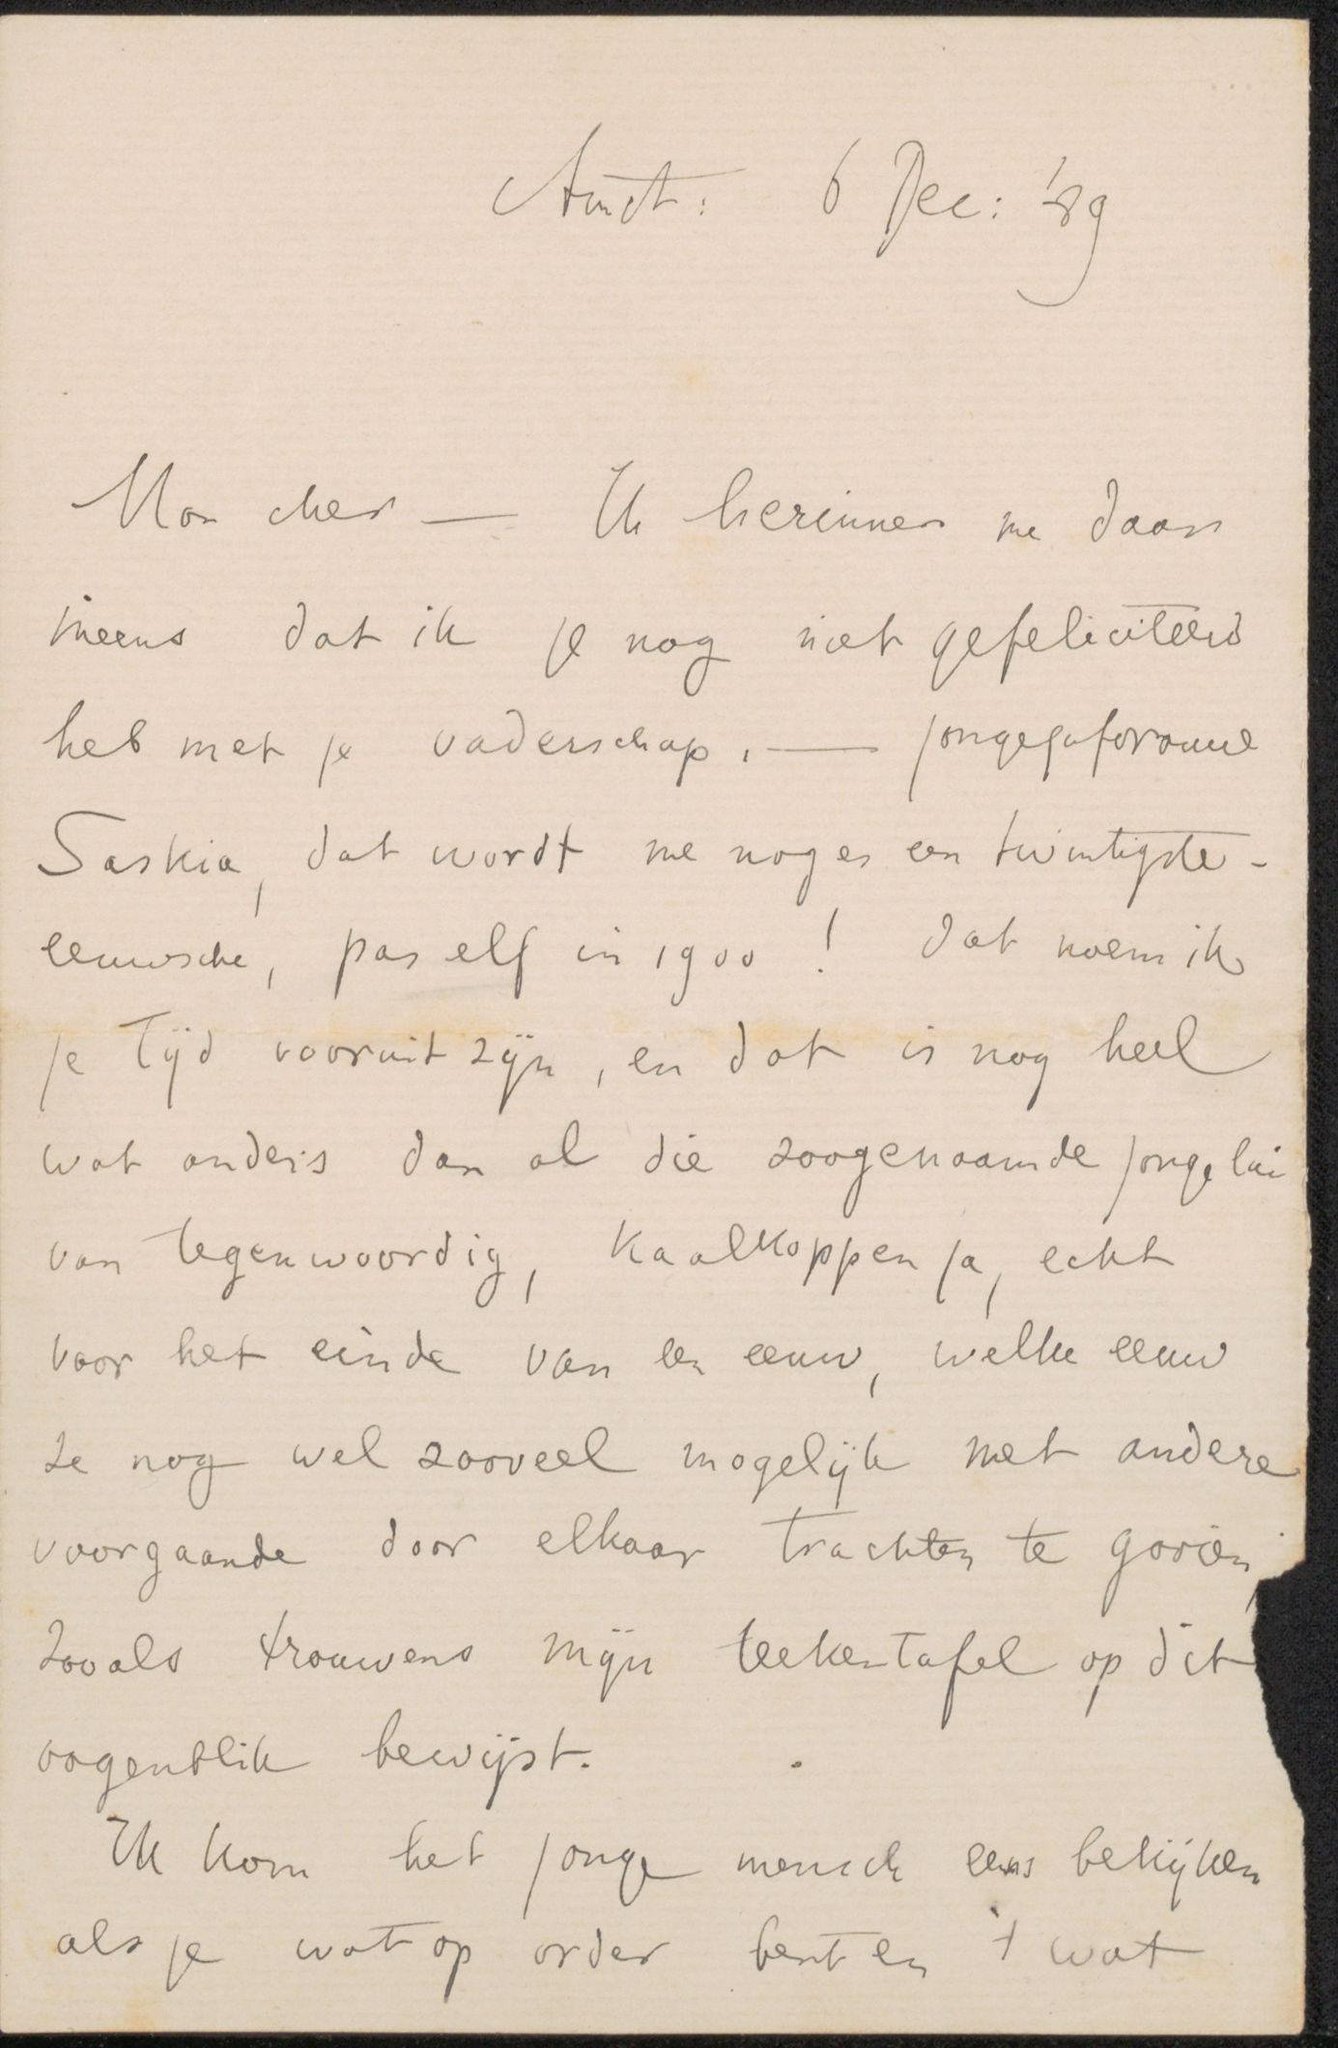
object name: letter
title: Brief aan Jan Veth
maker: isaac israels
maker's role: draughtsman, painter, print maker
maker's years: 1865-1934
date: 1889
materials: ink, paper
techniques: pen, writing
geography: amsterdam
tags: dordrecht, designer, jan veth, family life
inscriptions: collector's mark: ‘RPK’